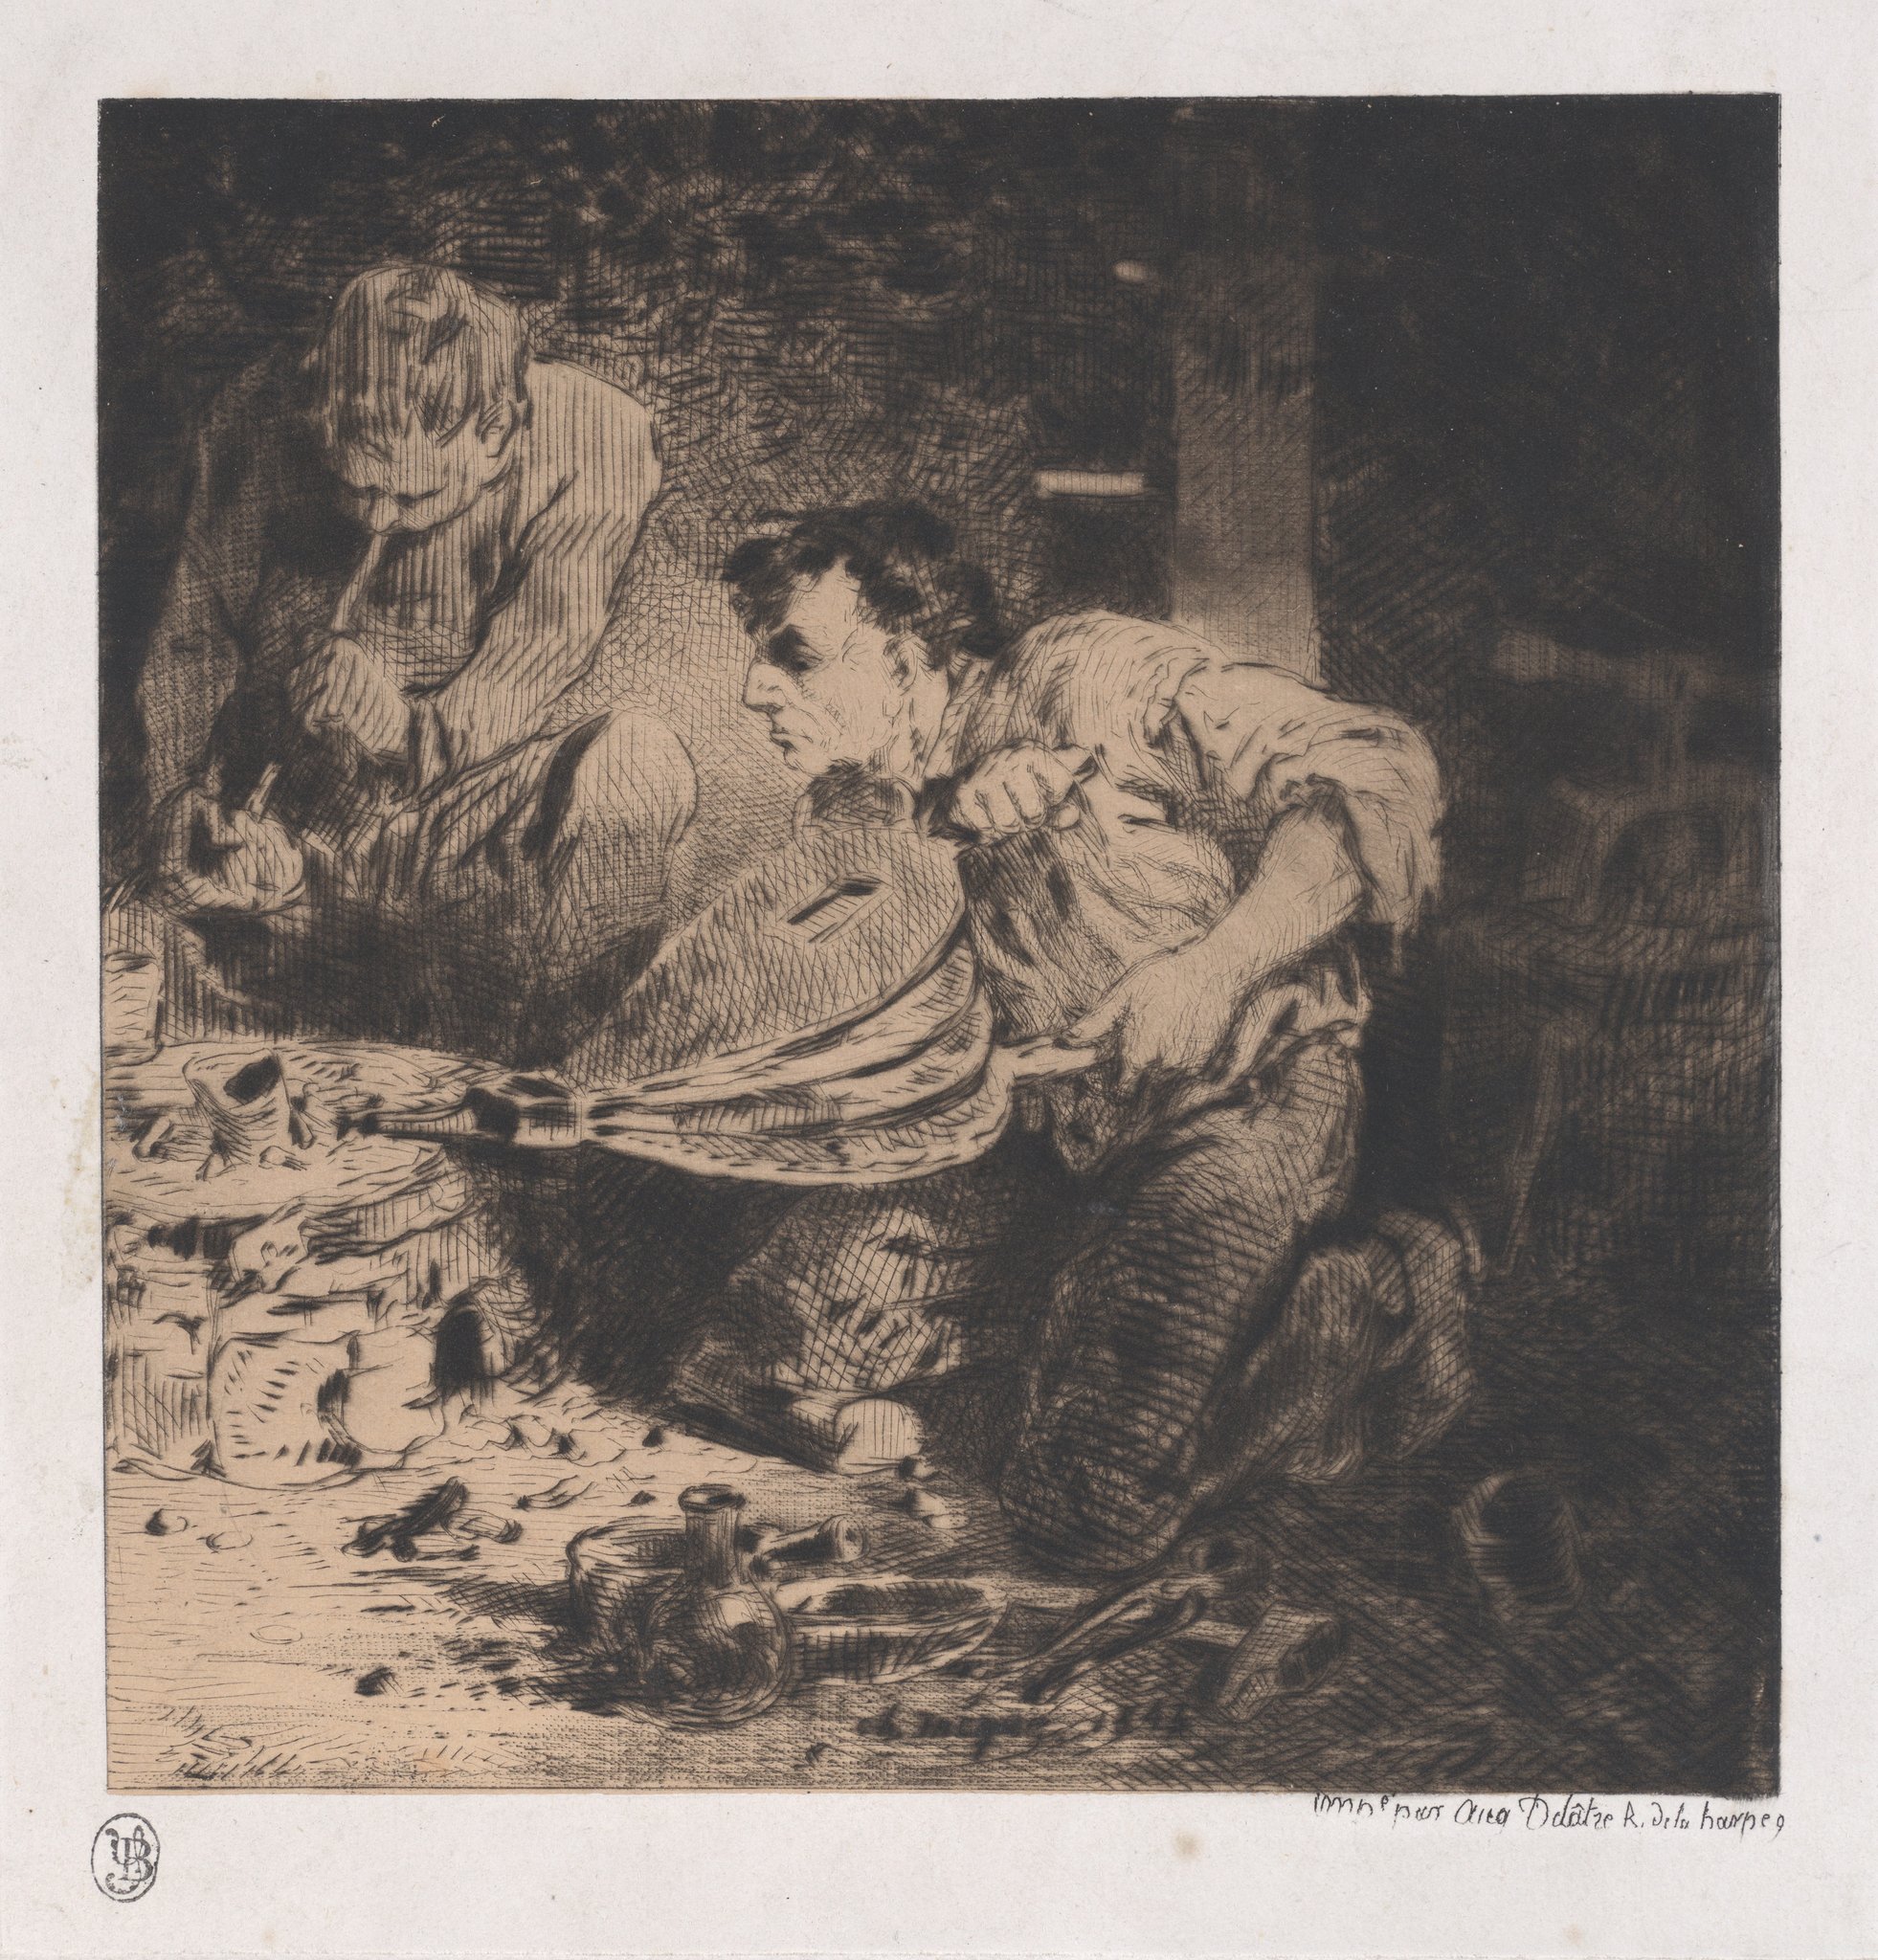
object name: print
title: The Counterfeiters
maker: charles émile jacque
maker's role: artist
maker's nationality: french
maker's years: 1813-1894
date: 1843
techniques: printmaking, drypoint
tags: men,bellows